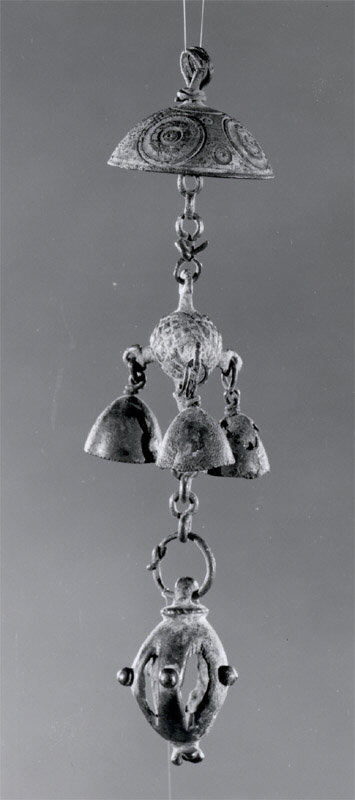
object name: bell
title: Bells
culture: iranian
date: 1000-1 BCE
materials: bronze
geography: iran